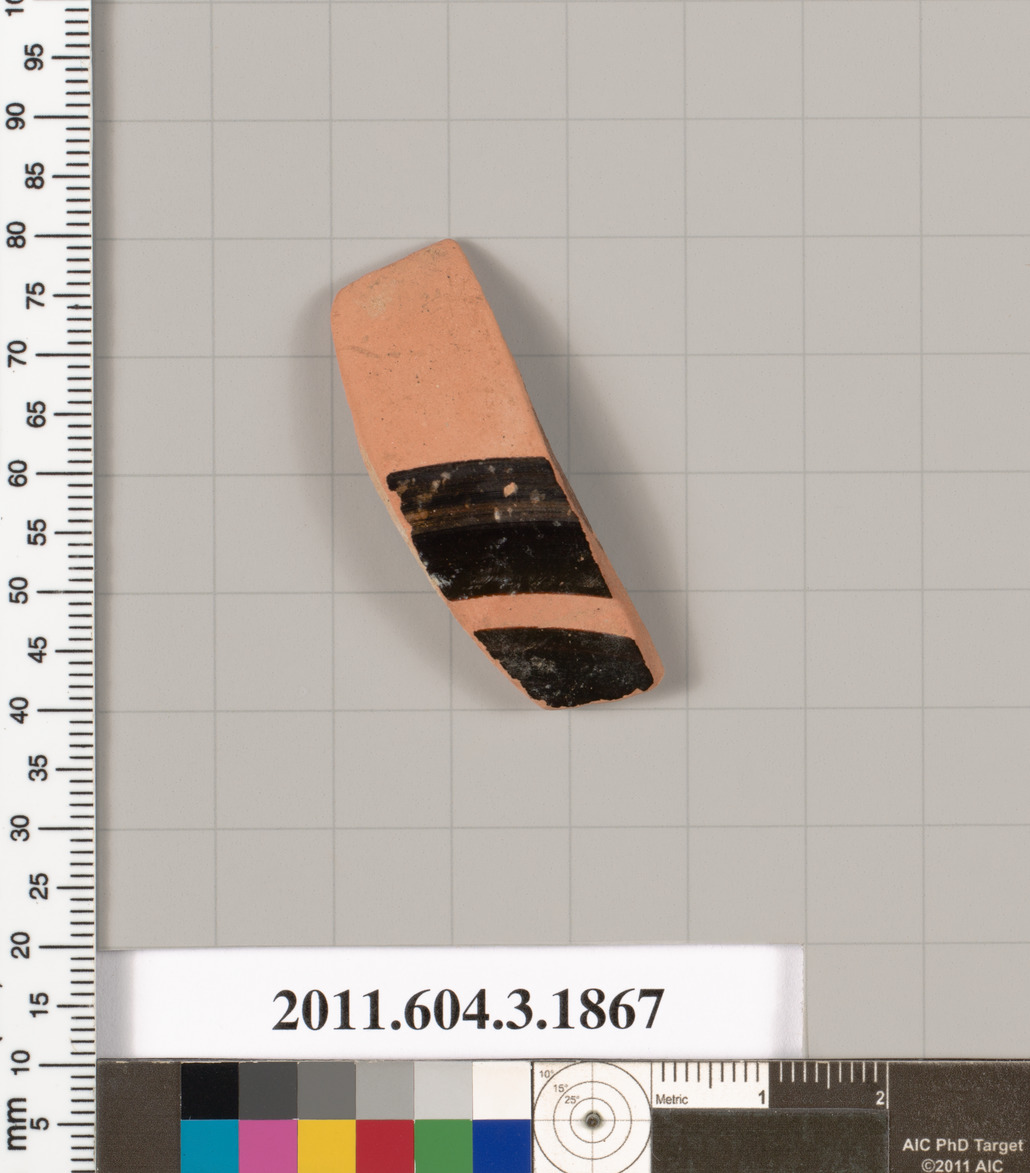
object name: kylix fragment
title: Terracotta fragment of a kylix: Lip cup (drinking cup)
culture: greek, attic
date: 560-525 BCE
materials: terracotta